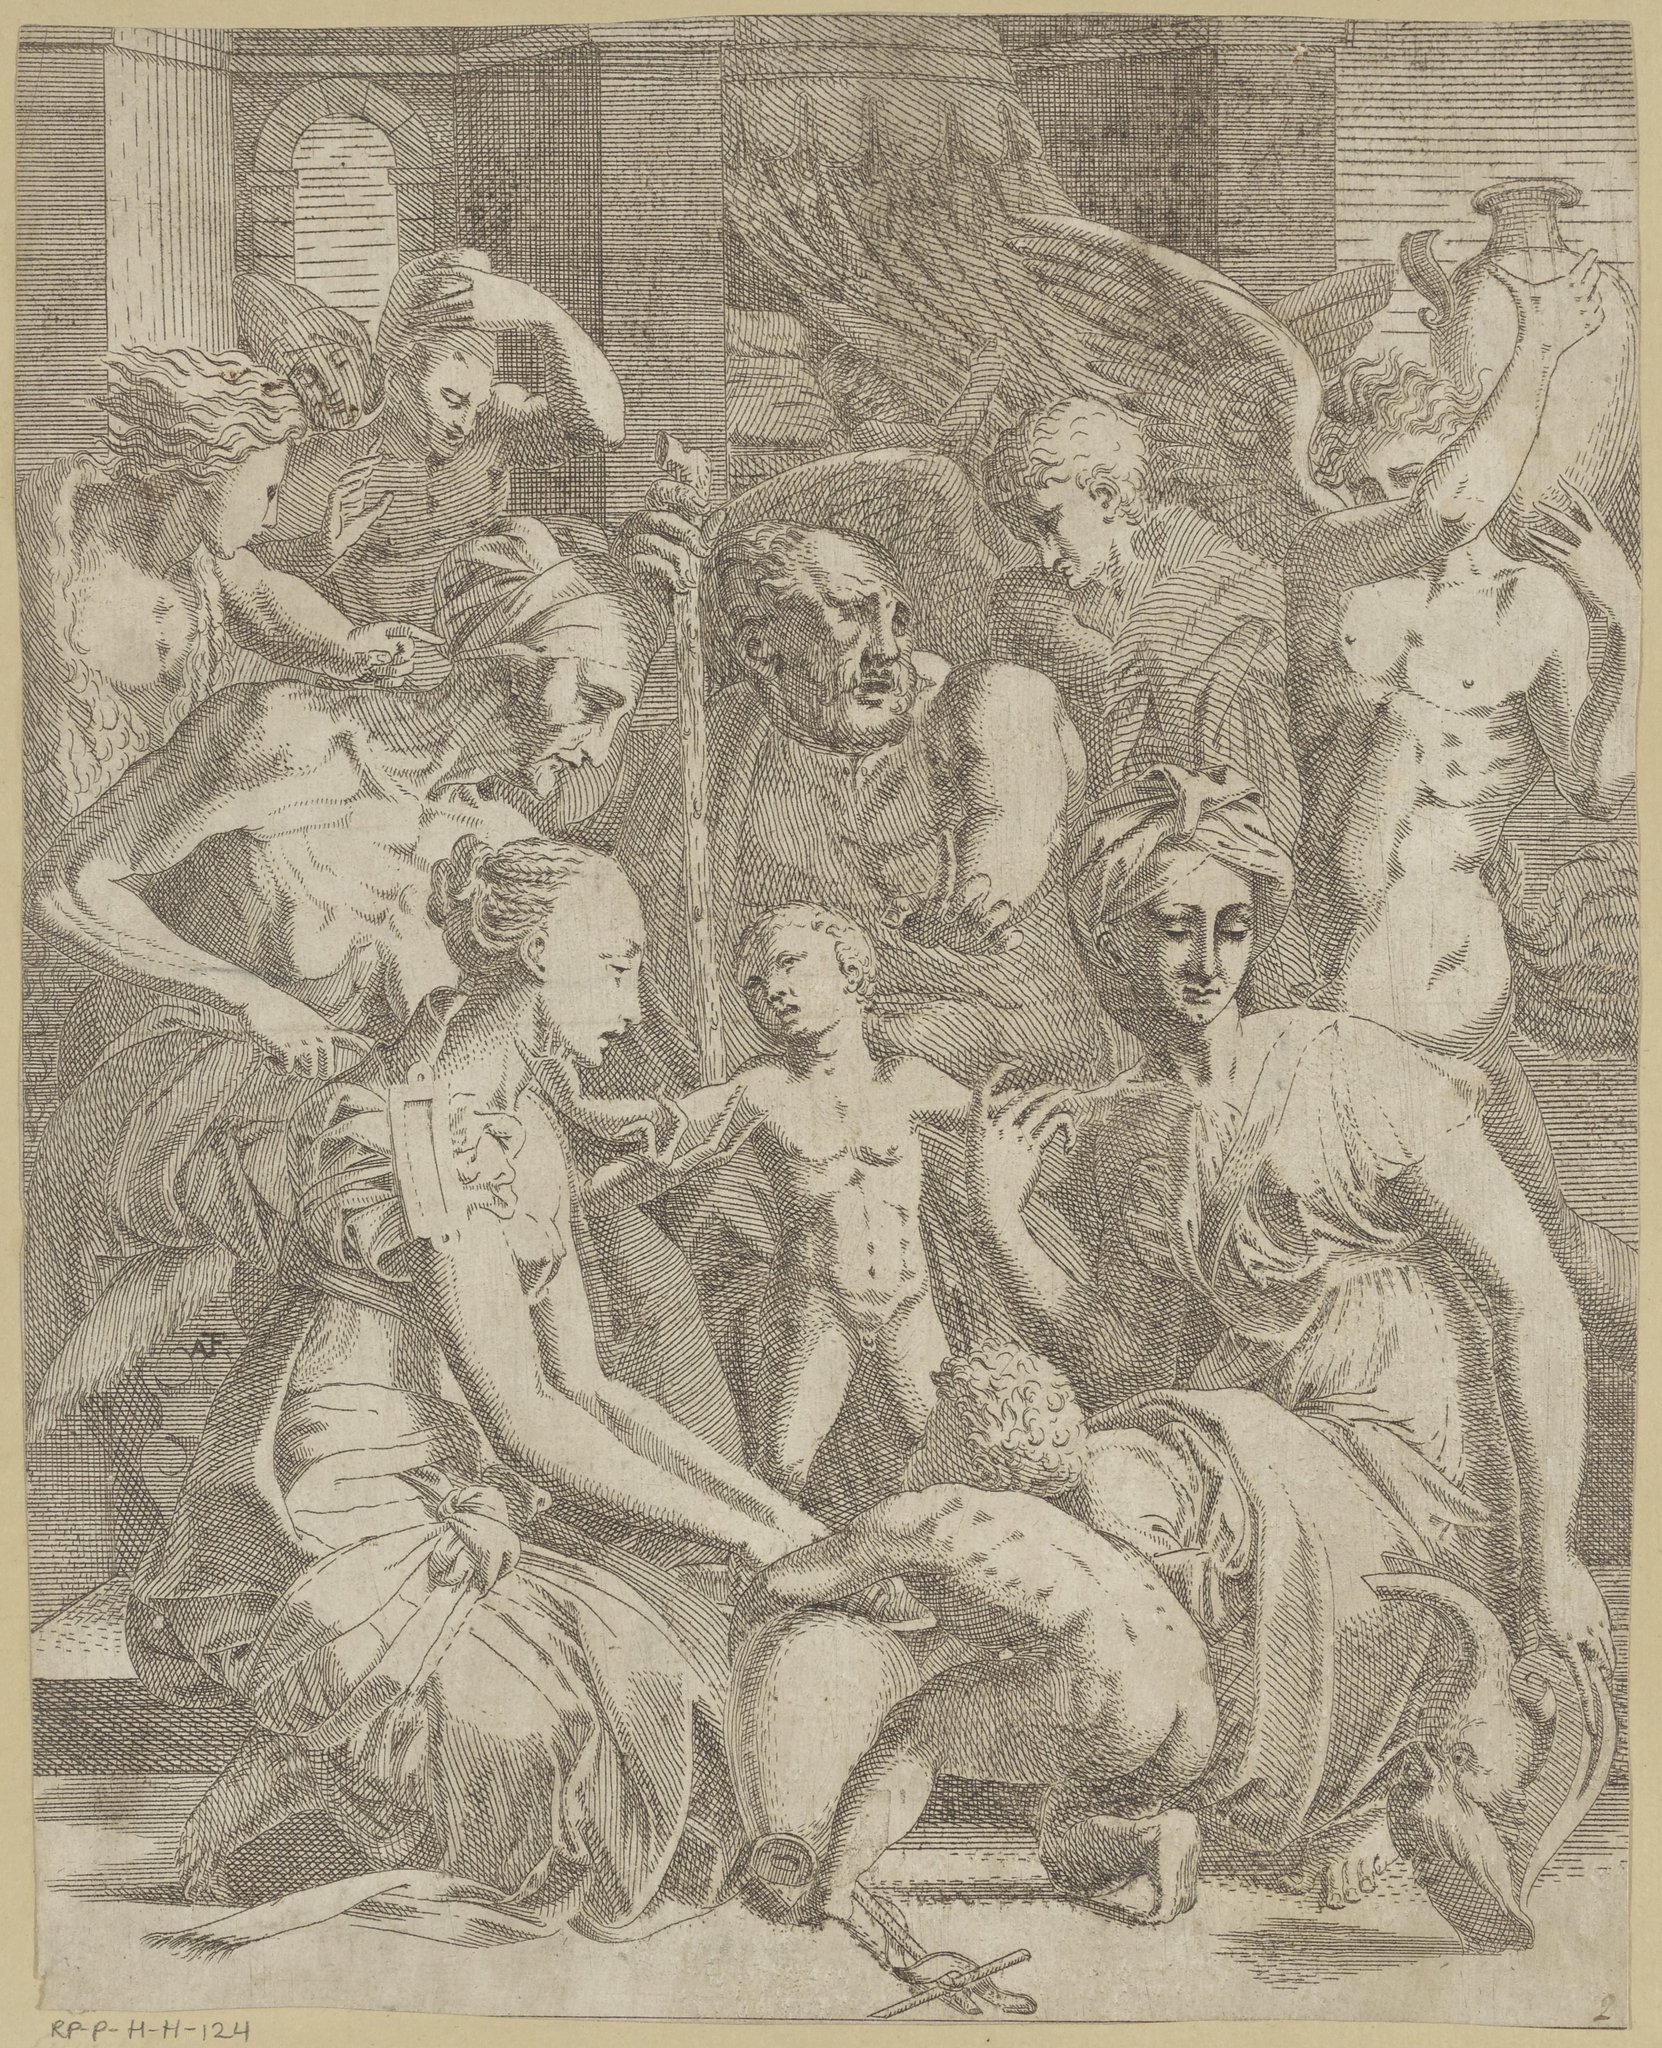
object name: print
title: Heilige Familie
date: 1544-1545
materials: paper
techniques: etching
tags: holy family, and derived representations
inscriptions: collector's mark: Lugt 11, number: ‘2’, collector's mark: ‘Hinloopen’, collector's mark: Lugt 10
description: De Heilige Familie met de jonge Johannes de Doper, Maria Magdalena, Elisabet, herders en engelen.